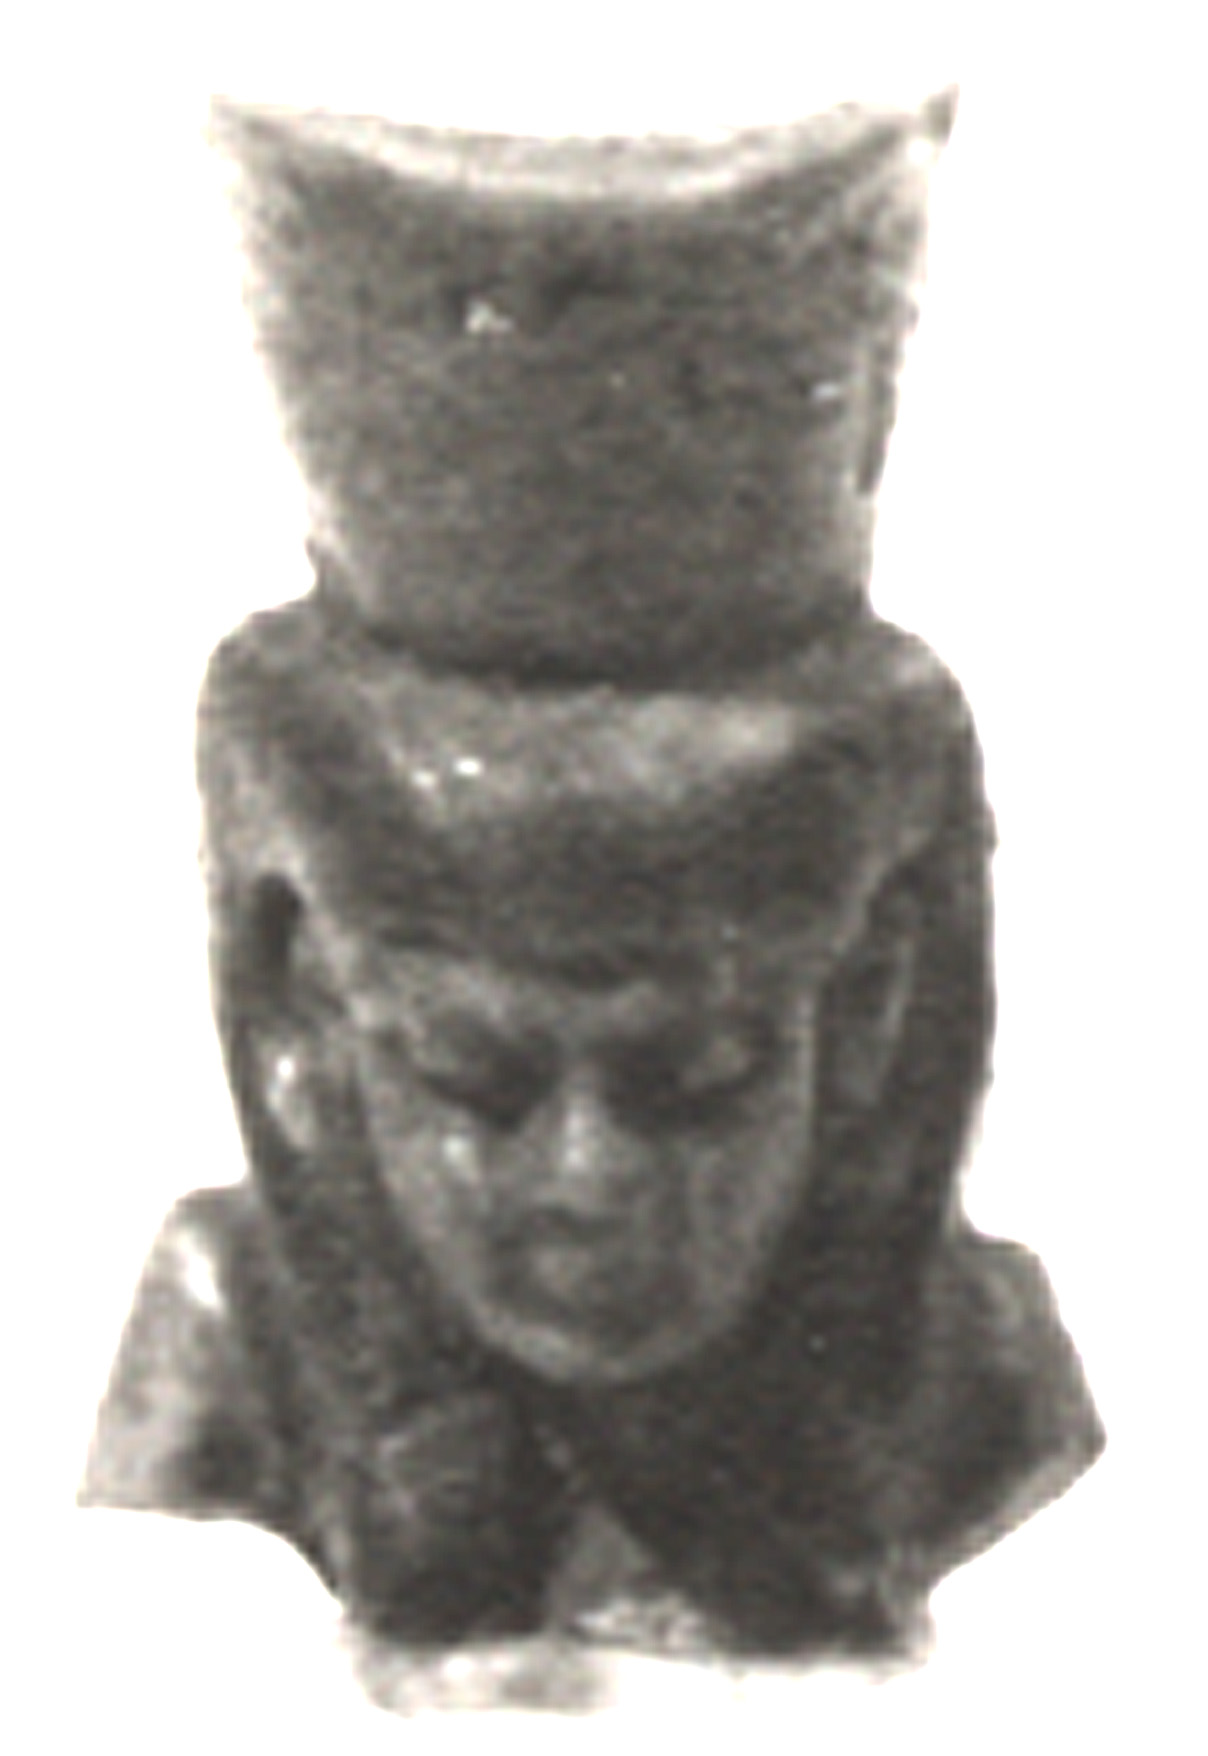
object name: amulet, head, goddess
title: Head of an Amulet Depicting a Goddess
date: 712-343 BCE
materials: faience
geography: egypt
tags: goddess